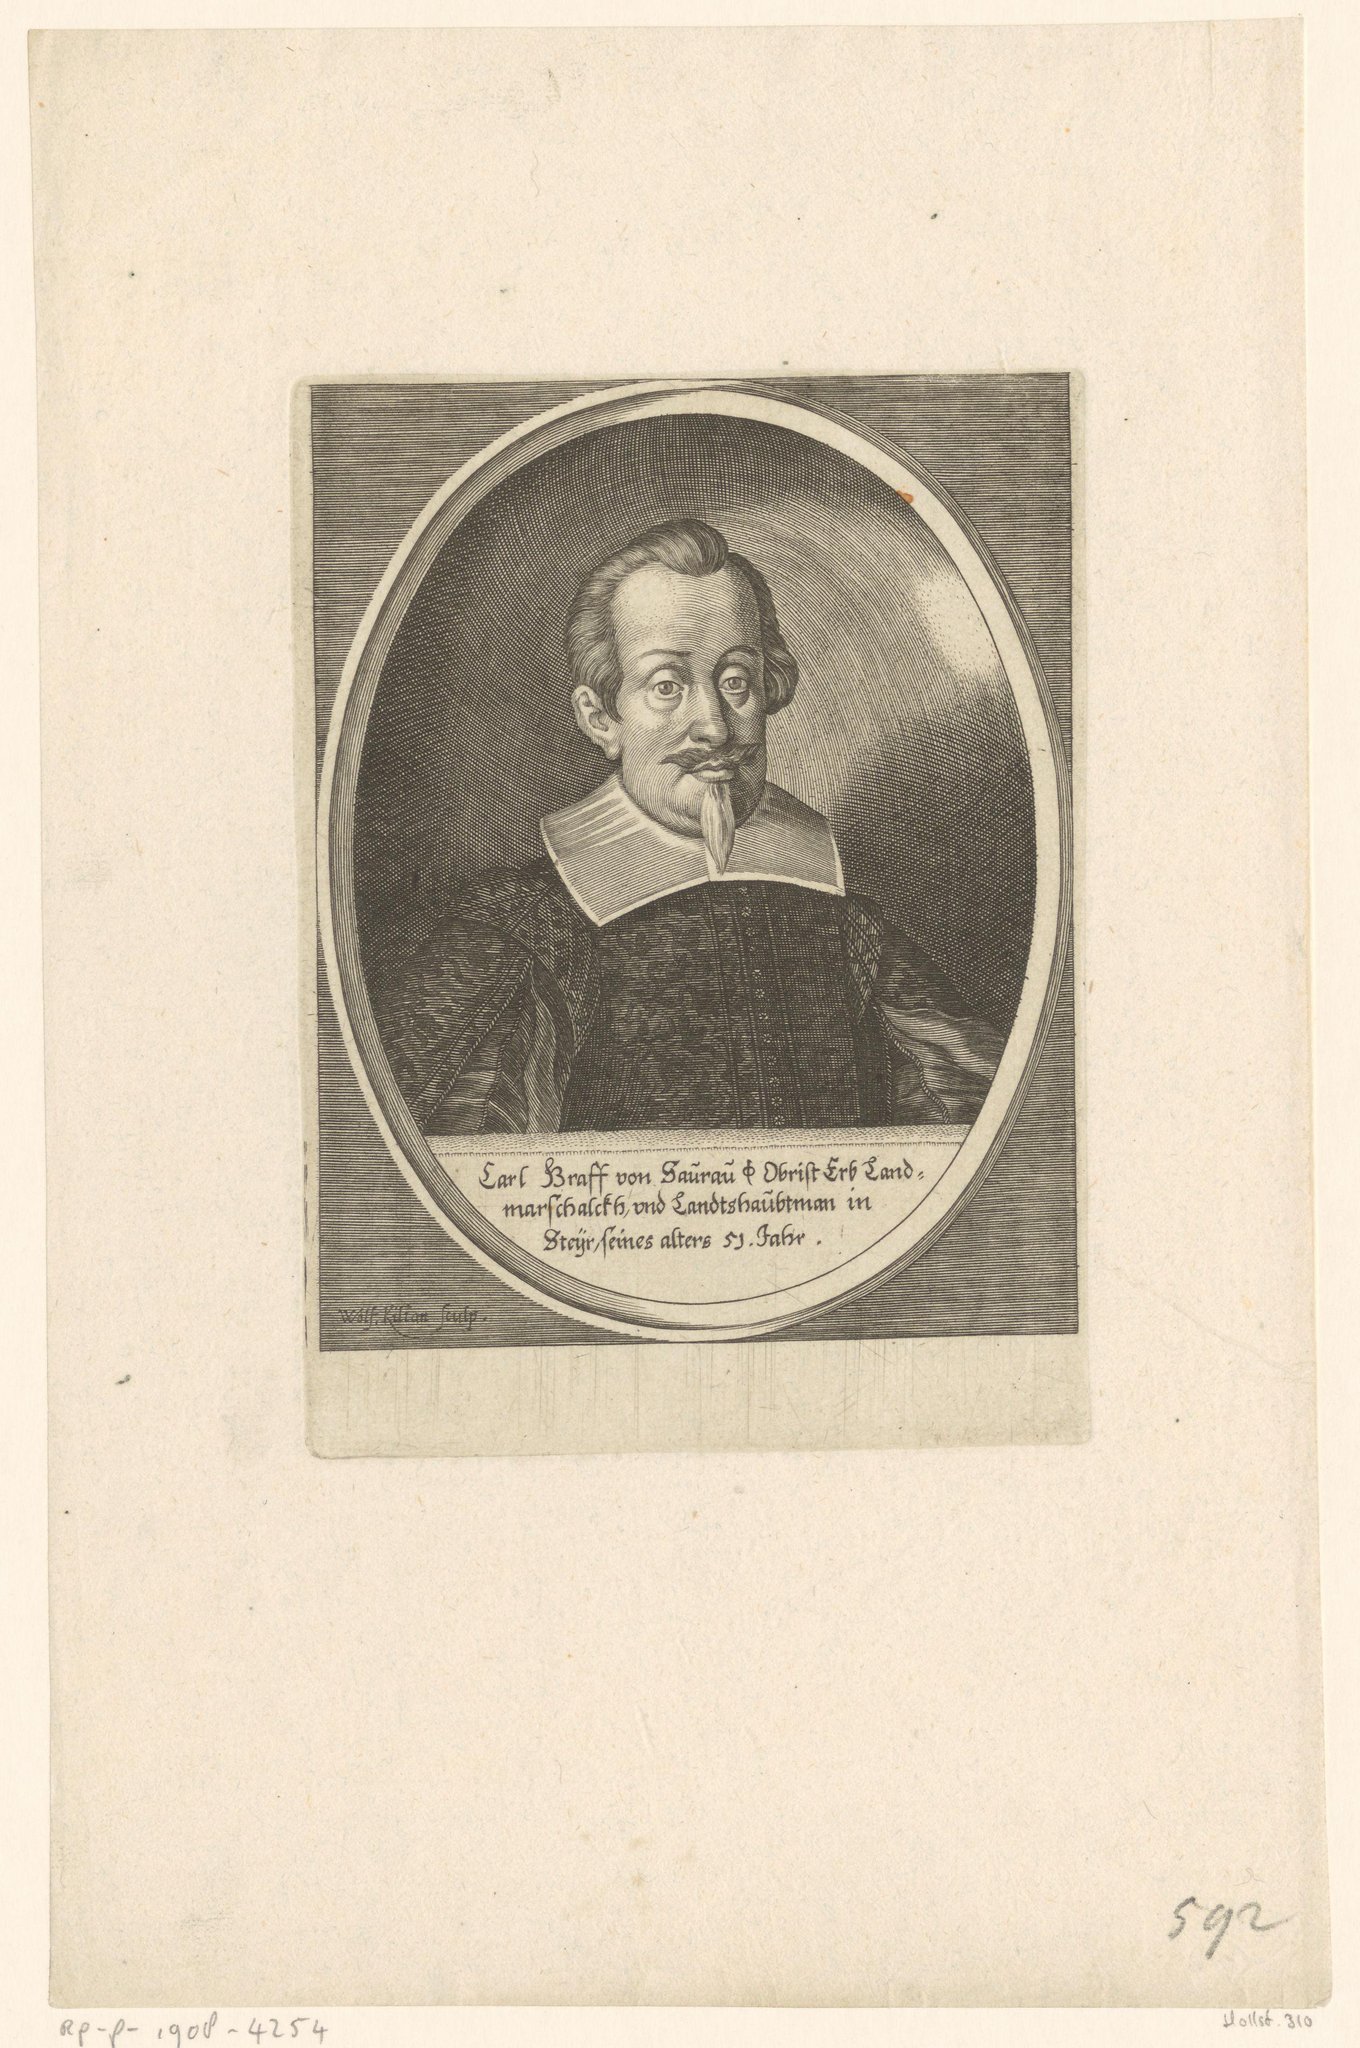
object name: print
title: Portret van Carl van Saurau op 51-jarige leeftijd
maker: wolfgang kilian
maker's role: print maker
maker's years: 1581-1662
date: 1591-1662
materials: paper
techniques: engraving, etching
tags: historical persons, officer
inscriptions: collector's mark: Lugt 2228